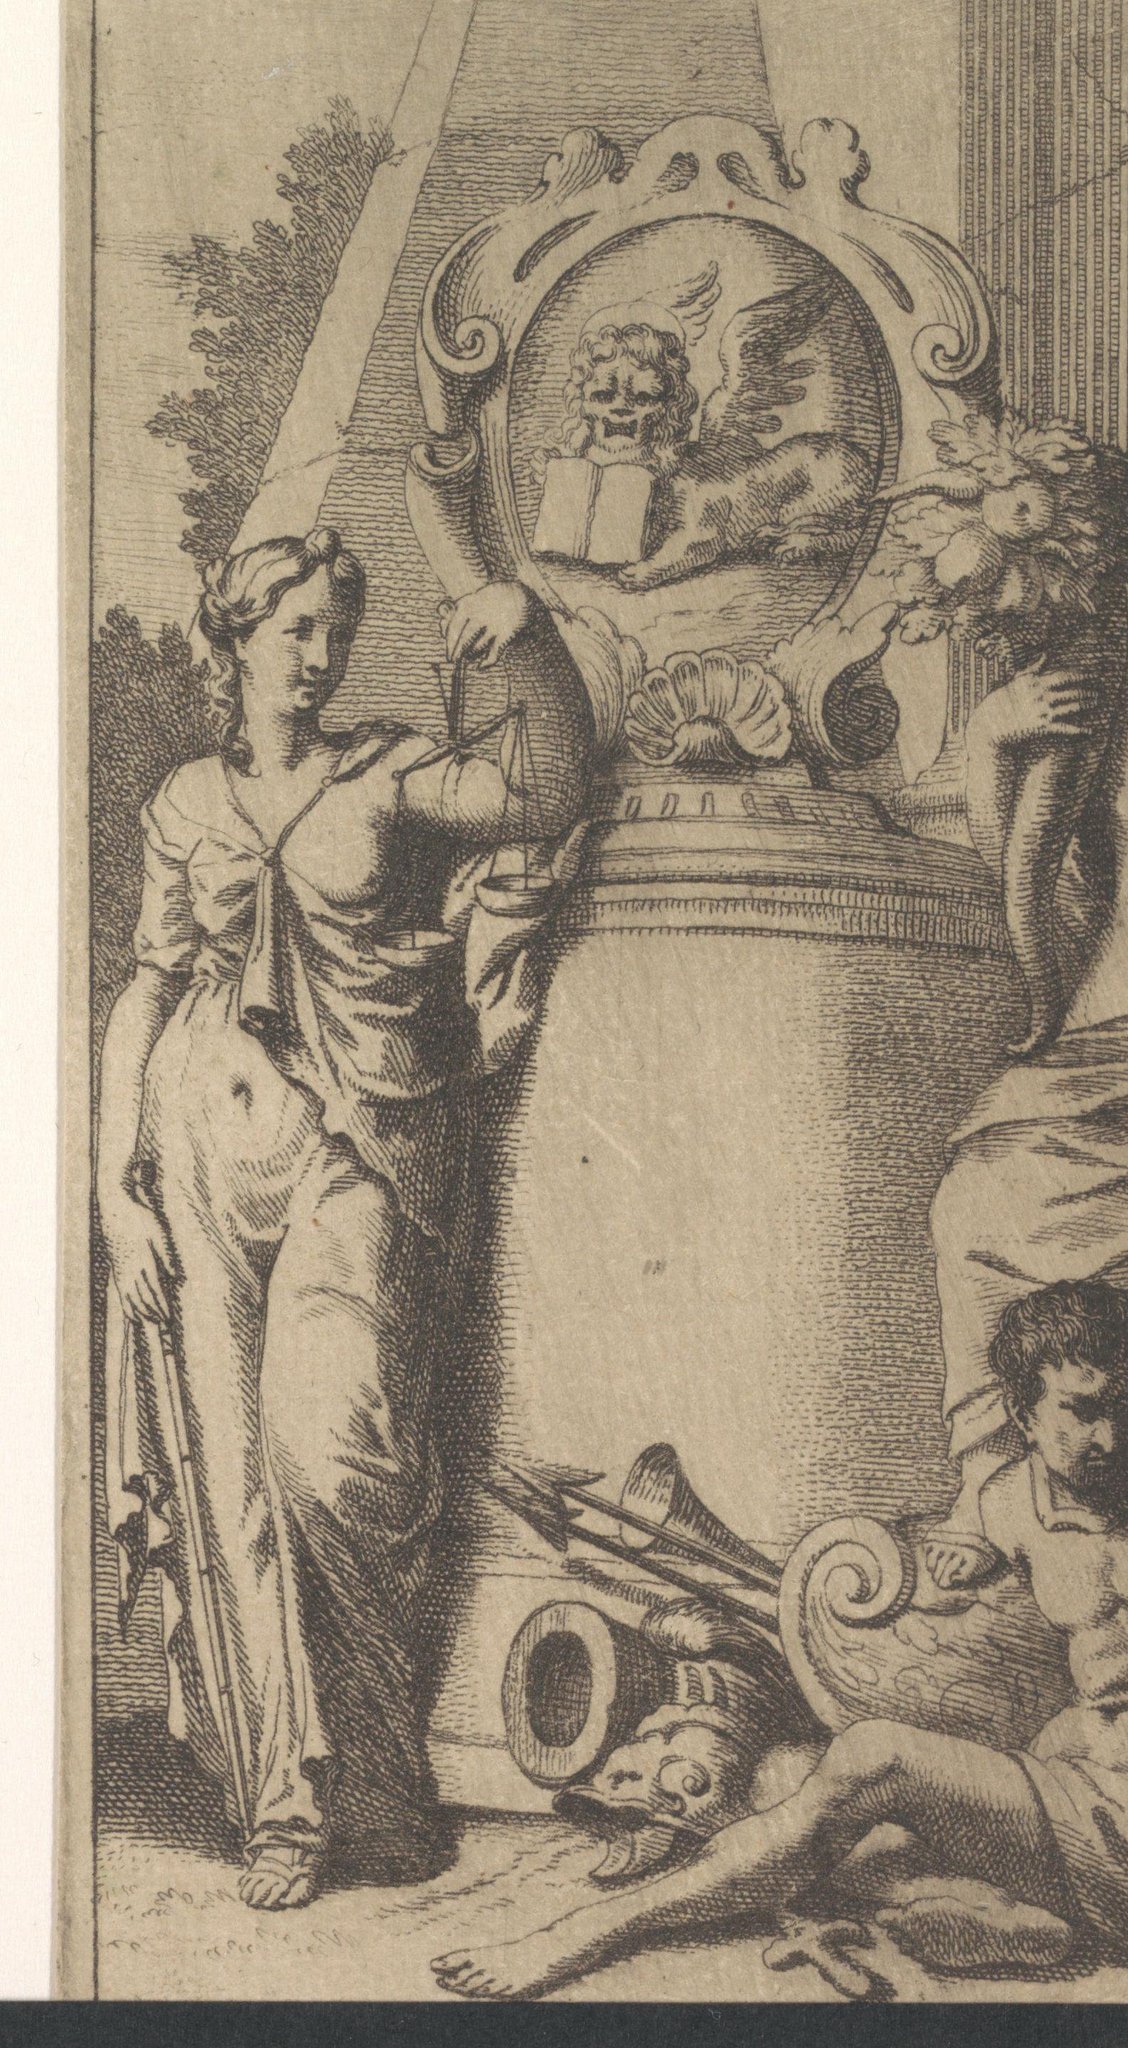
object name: print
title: Vignet met Apollo en vrouwelijke allegorische figuur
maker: Anonymous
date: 1700-1800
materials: paper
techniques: engraving, etching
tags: (story of) apollo (phoebus), monument, statue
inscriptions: inscription: ‘Elter / No’, collector's mark: Lugt 240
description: Een vrouw met vleugels aan haar hoofd en in haar hand een hand op een stok en de god Apollo staan naast een monument.